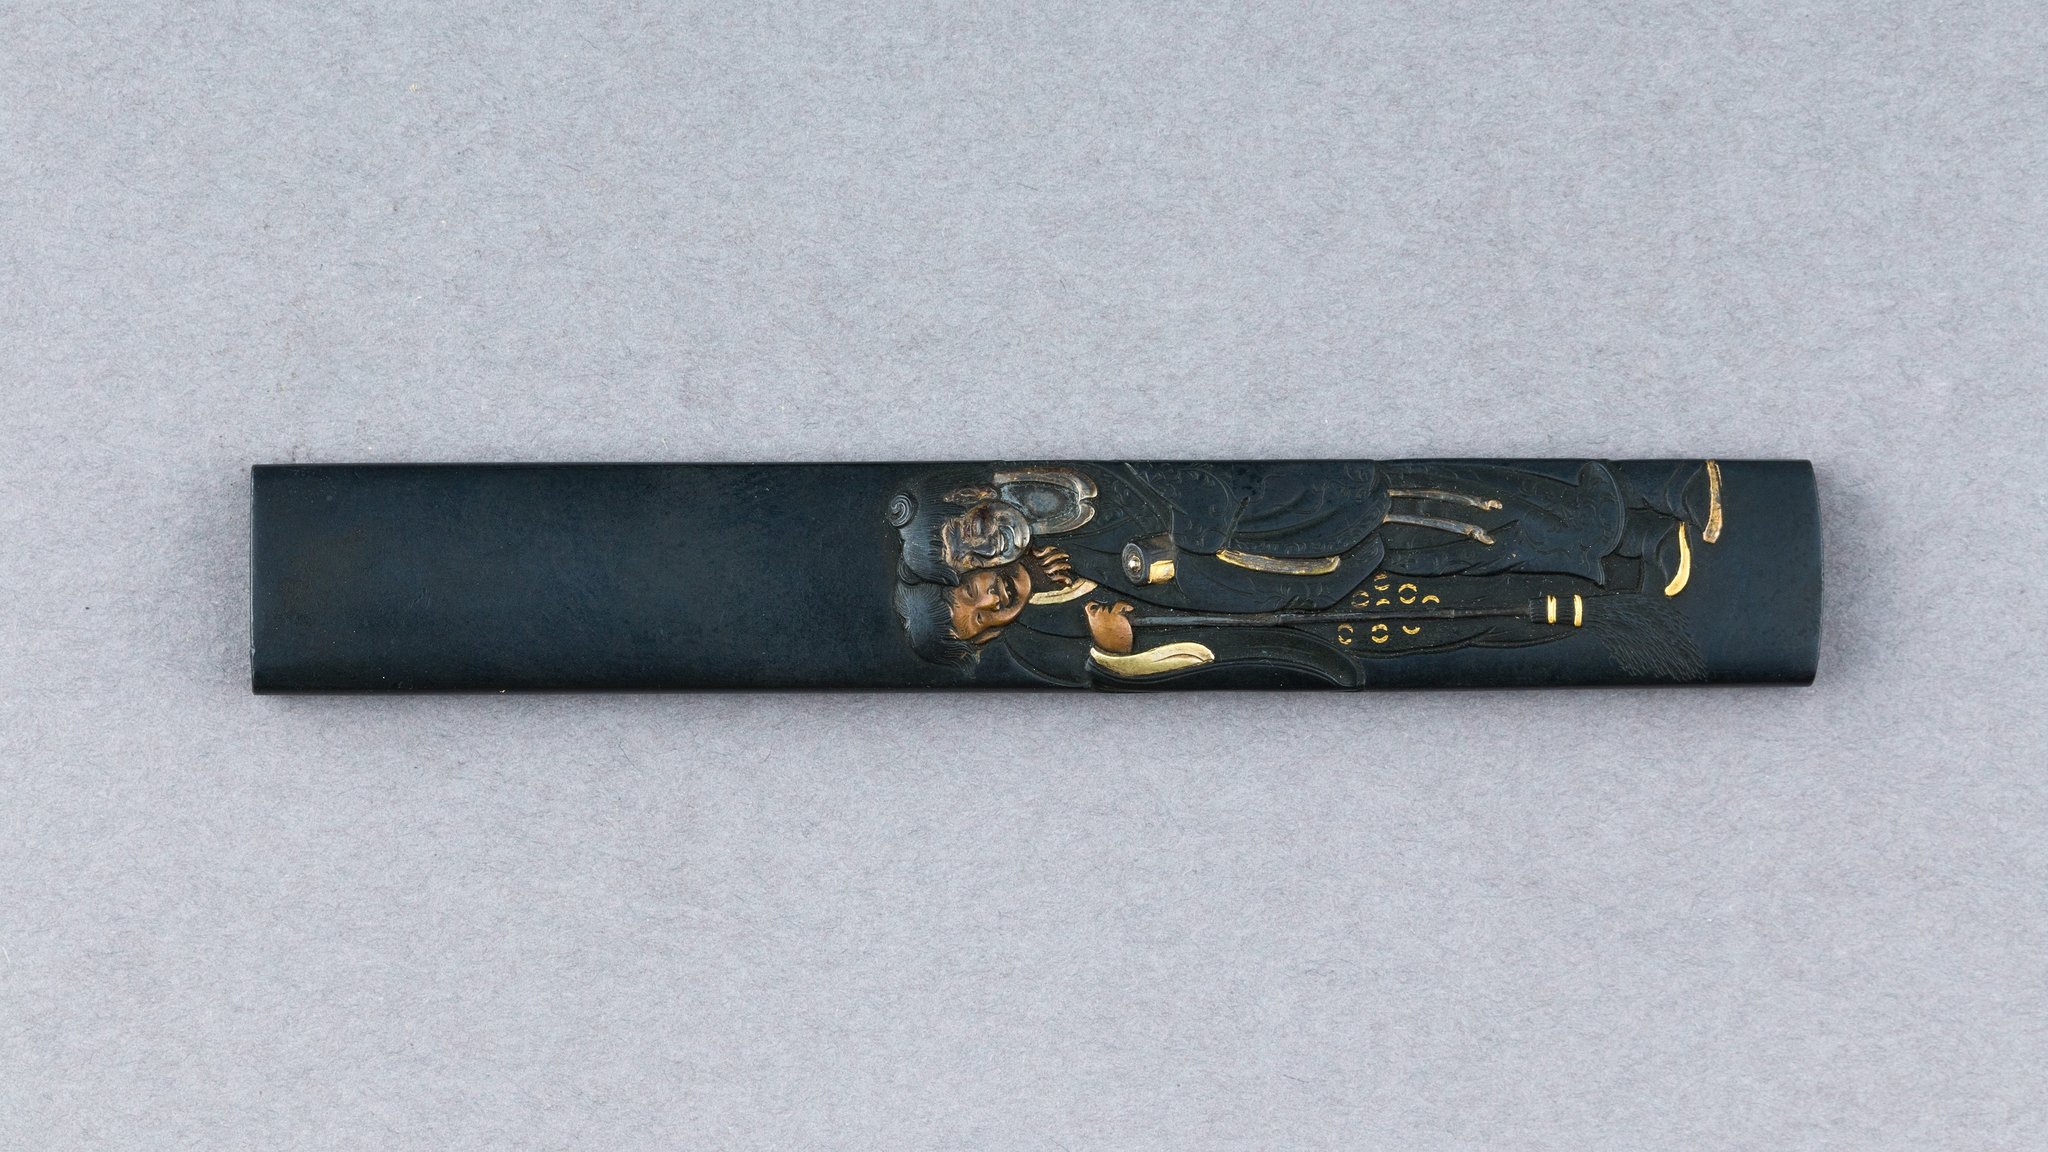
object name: knife handle kozuka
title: Knife Handle (Kozuka)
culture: japanese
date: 1615-1868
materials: copper, gold alloy, silver alloy, gold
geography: japan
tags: men